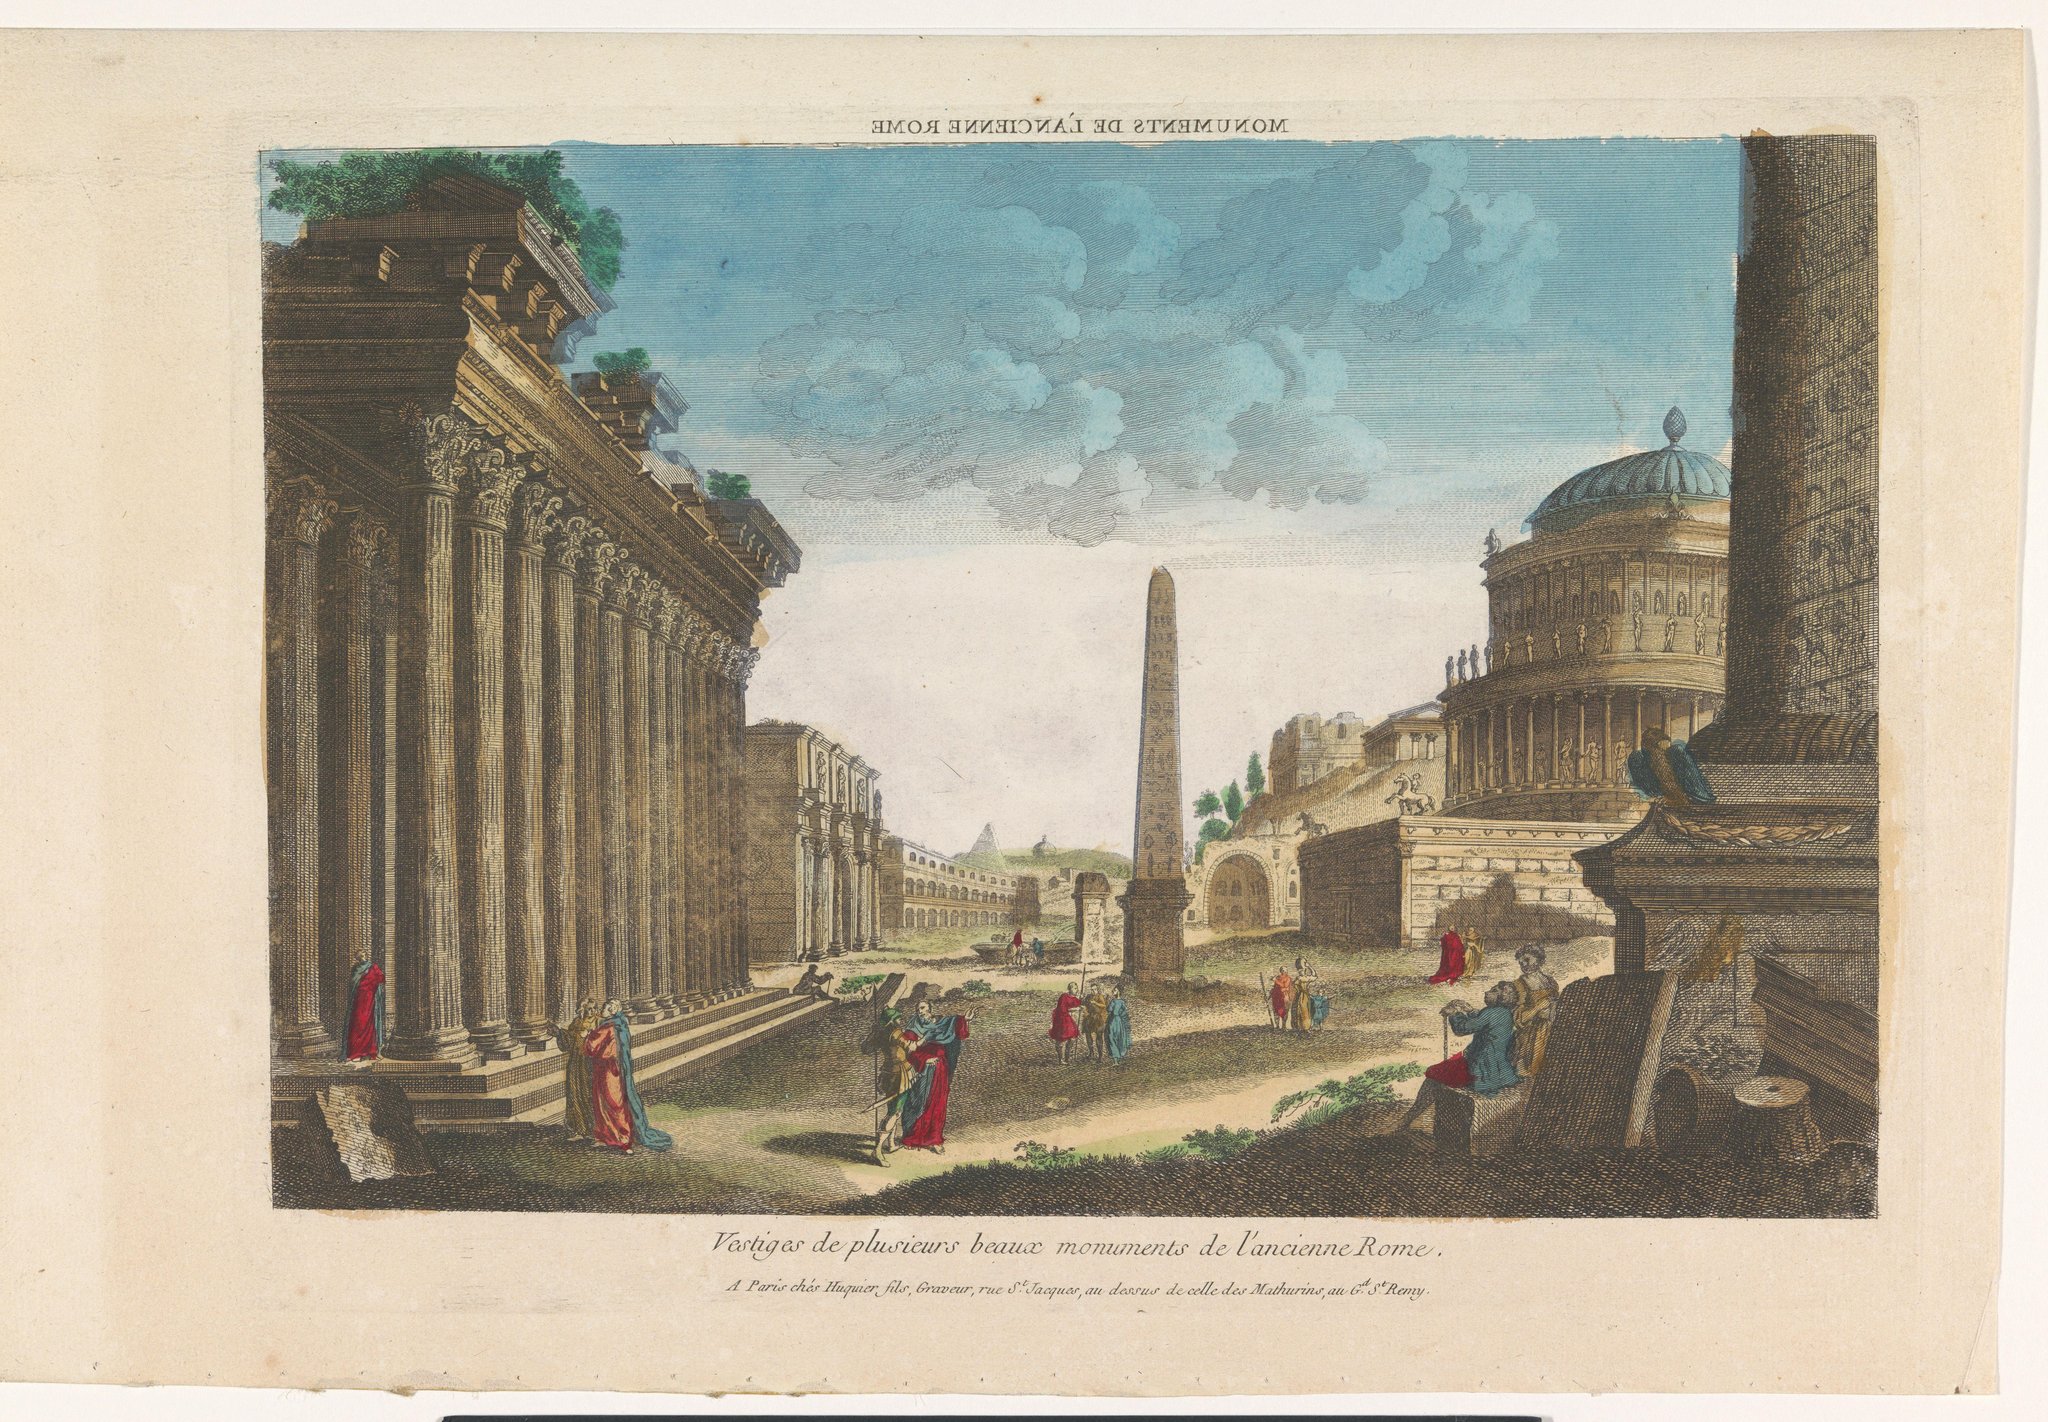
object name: opticaprent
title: Monuments de l'ancienne Rome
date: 1735-1805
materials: paper, watercolor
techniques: brush, etching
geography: paris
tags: obelisk, needle (+ city(-scape) with figures, staffage), column (marking grave), triumphal arch, mausoleum, temple, shrine ~ roman religion, landscape with ruins (+ city(-scape) with figures, staffage), arch of constantine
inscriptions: collector's mark: Lugt 2166, watermark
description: Bij de brokstukken staan en zitten figuren.